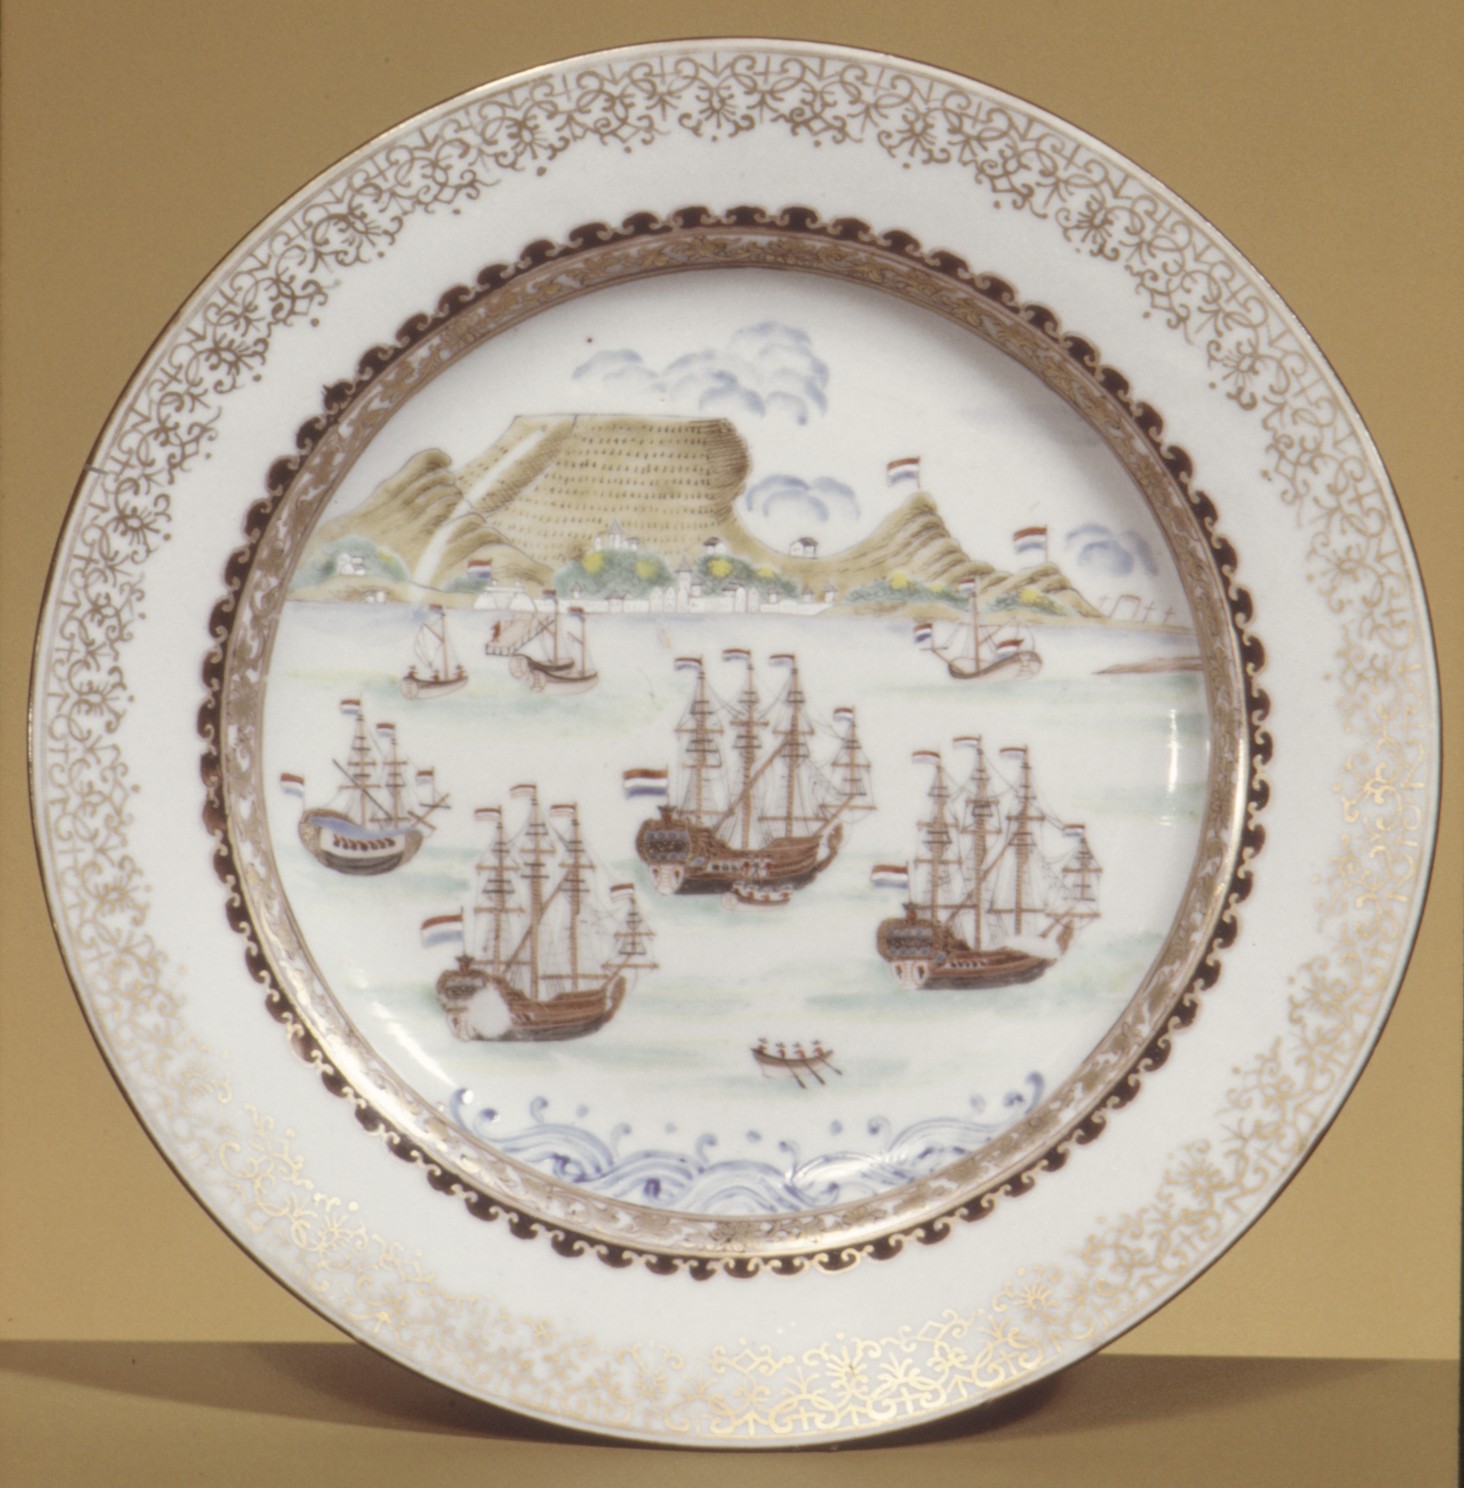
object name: plate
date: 1740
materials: hard paste porcelain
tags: ships